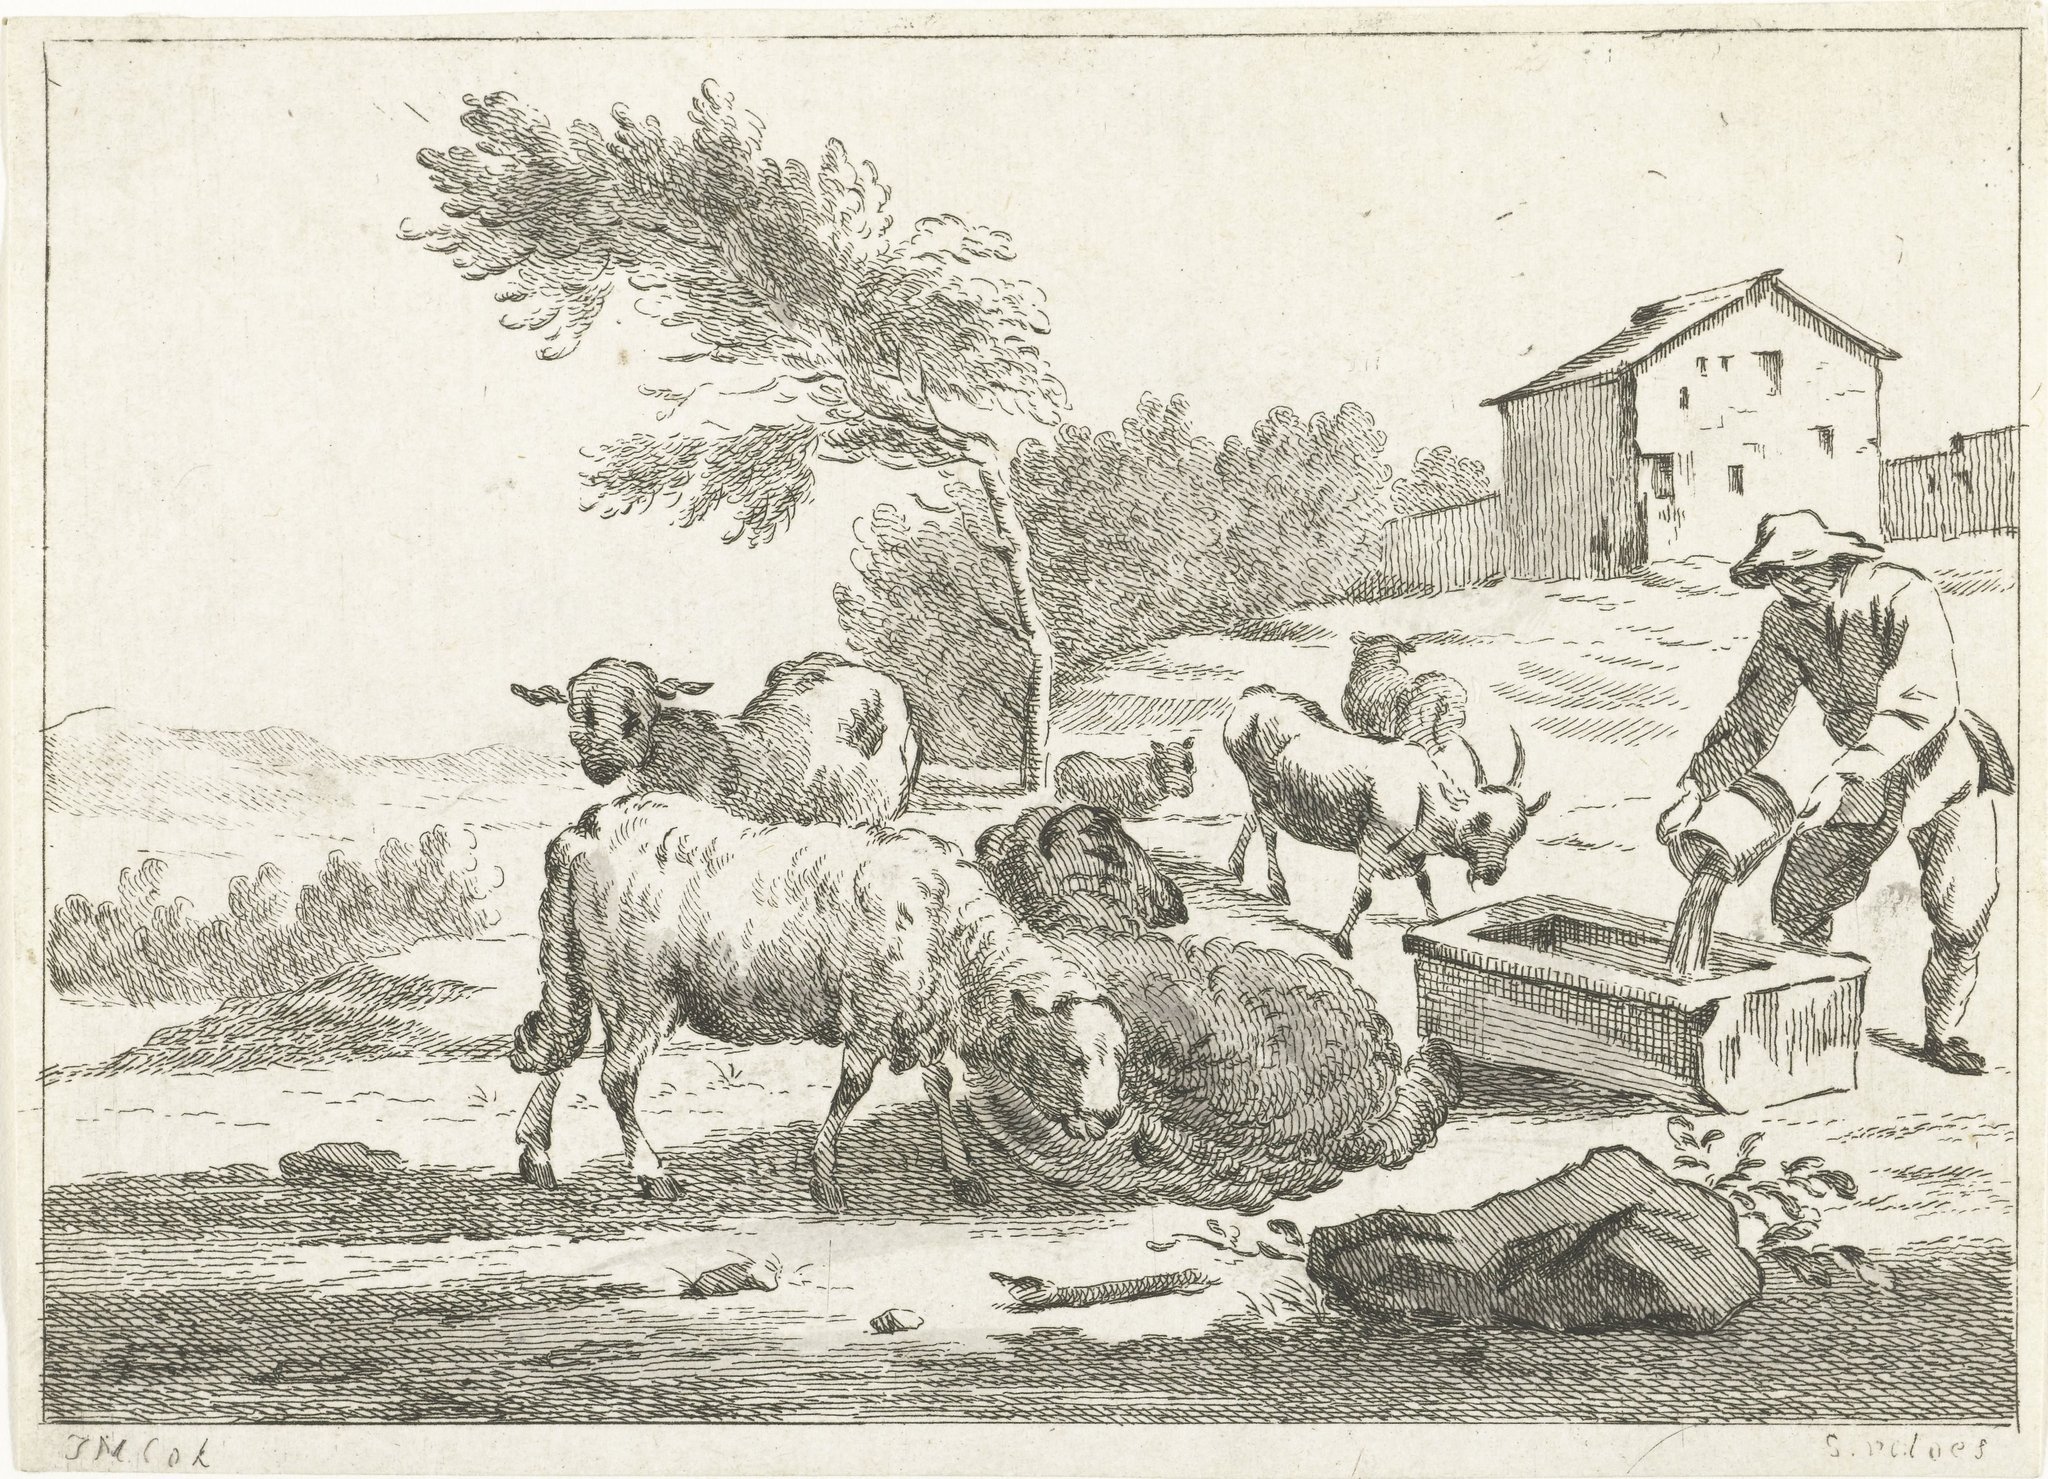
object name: print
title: Schaapherder met zijn kudde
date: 1735-1771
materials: paper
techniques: etching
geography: amsterdam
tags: sheep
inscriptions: number: ‘3’, collector's mark: Lugt 2228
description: Een schaapherder stort voer in de voederbak. Eromheen schapen en geiten.